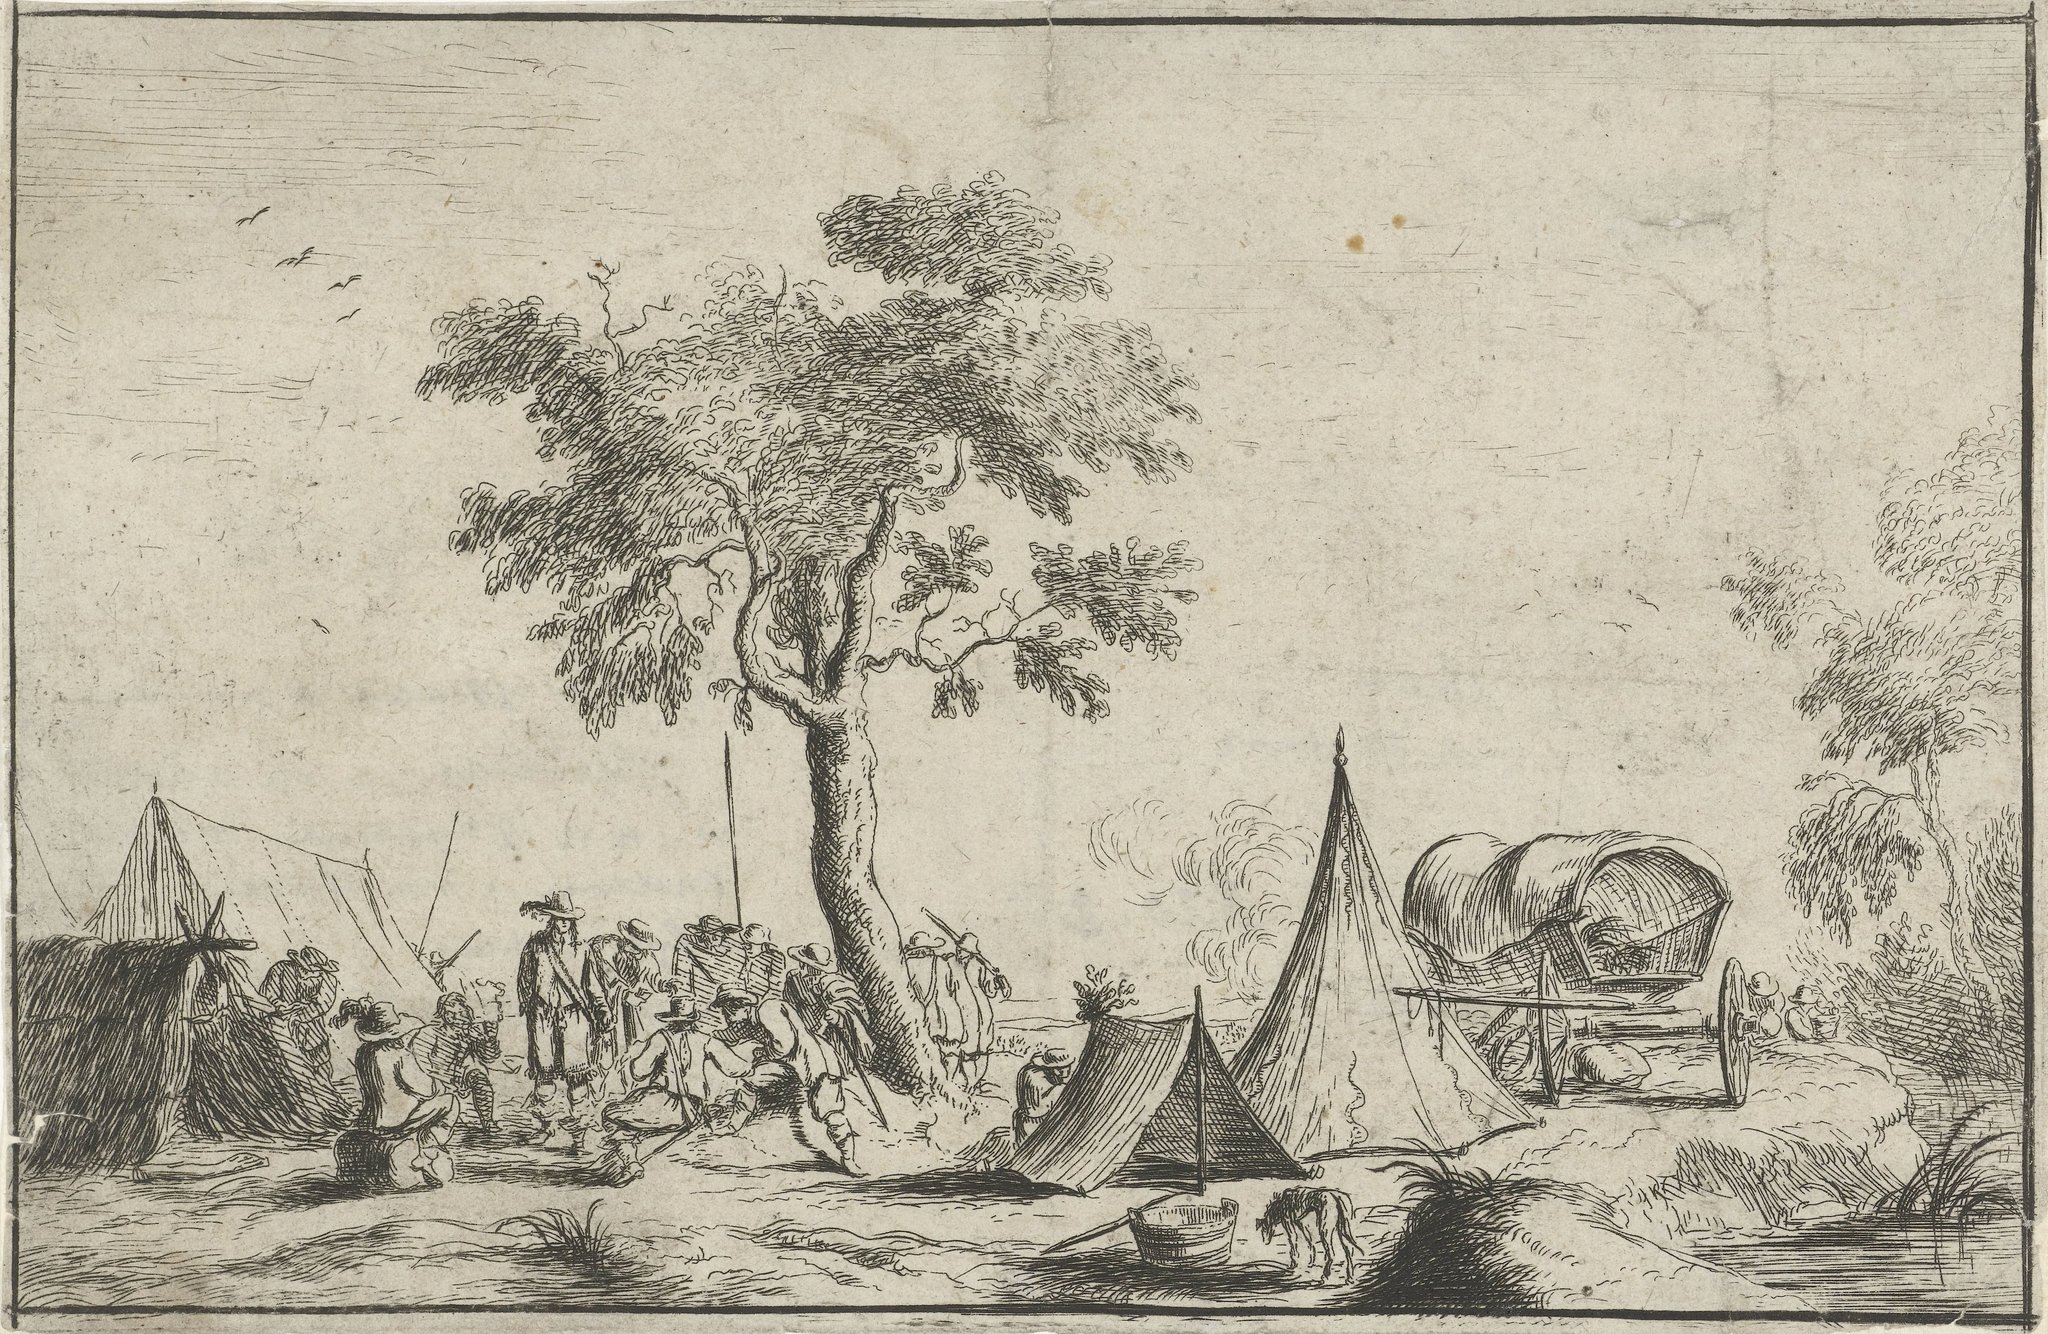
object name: print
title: Kampement met een spitse tent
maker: robert van den hoecke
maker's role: draughtsman, painter, print maker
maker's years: 1622-1668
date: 1632-1668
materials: paper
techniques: etching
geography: southern netherlands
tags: tent, covered wagon, hooded wagon, tent-camp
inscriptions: collector's mark: Lugt 2228